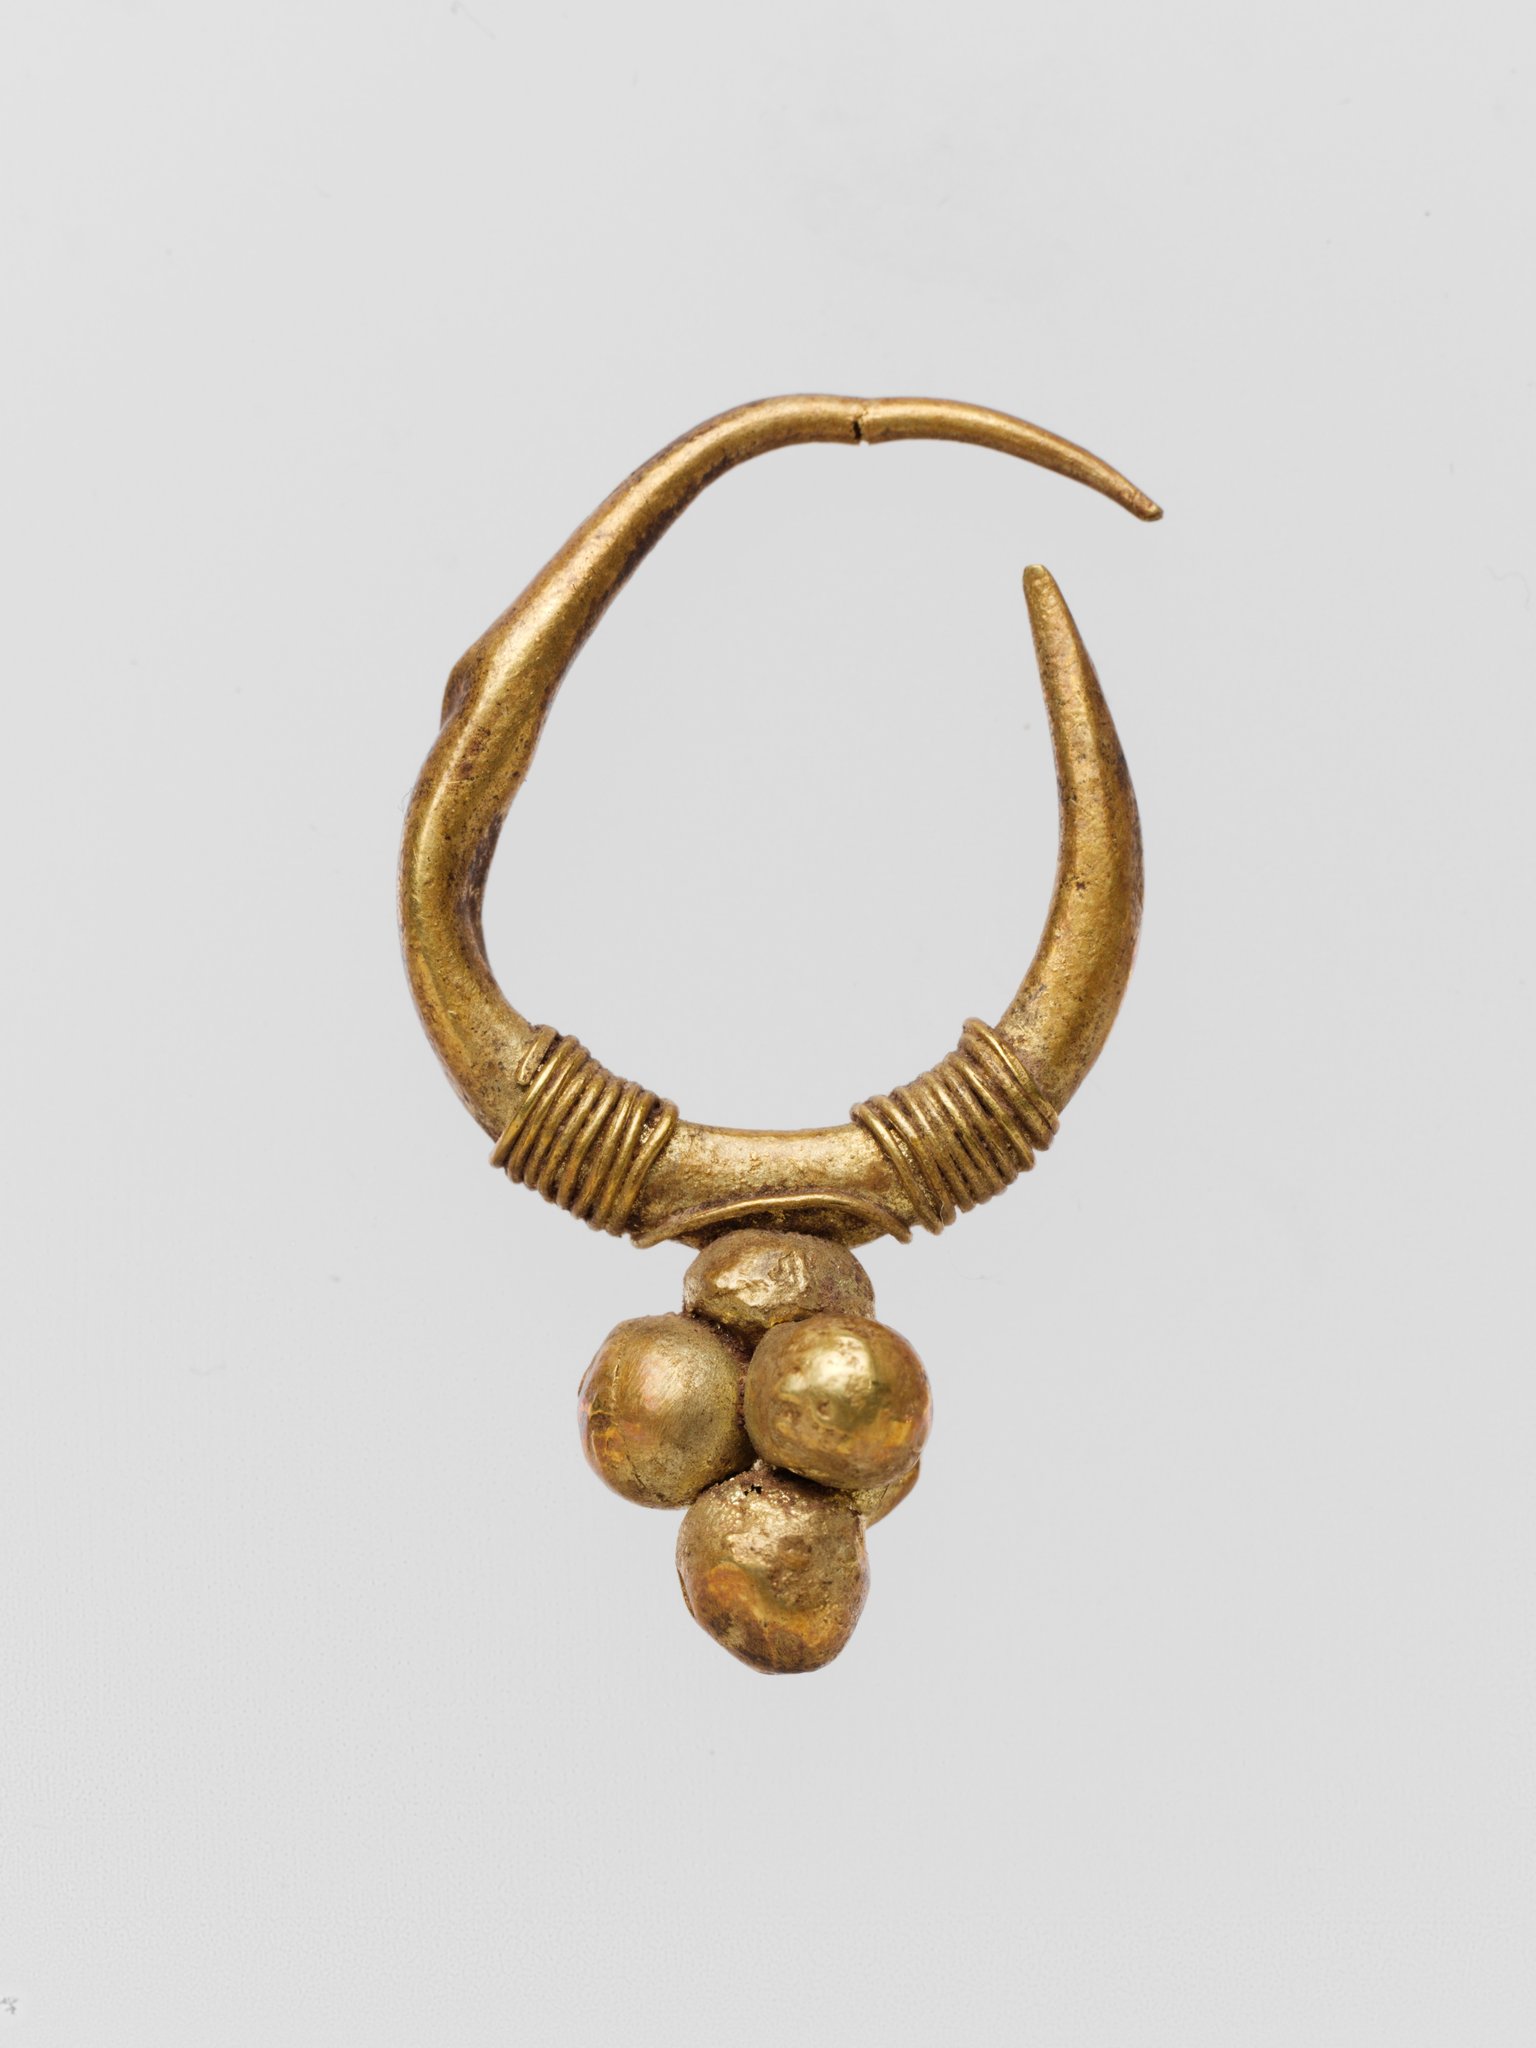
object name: earring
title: Gold earring with clustered sphere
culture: roman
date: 101-300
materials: gold